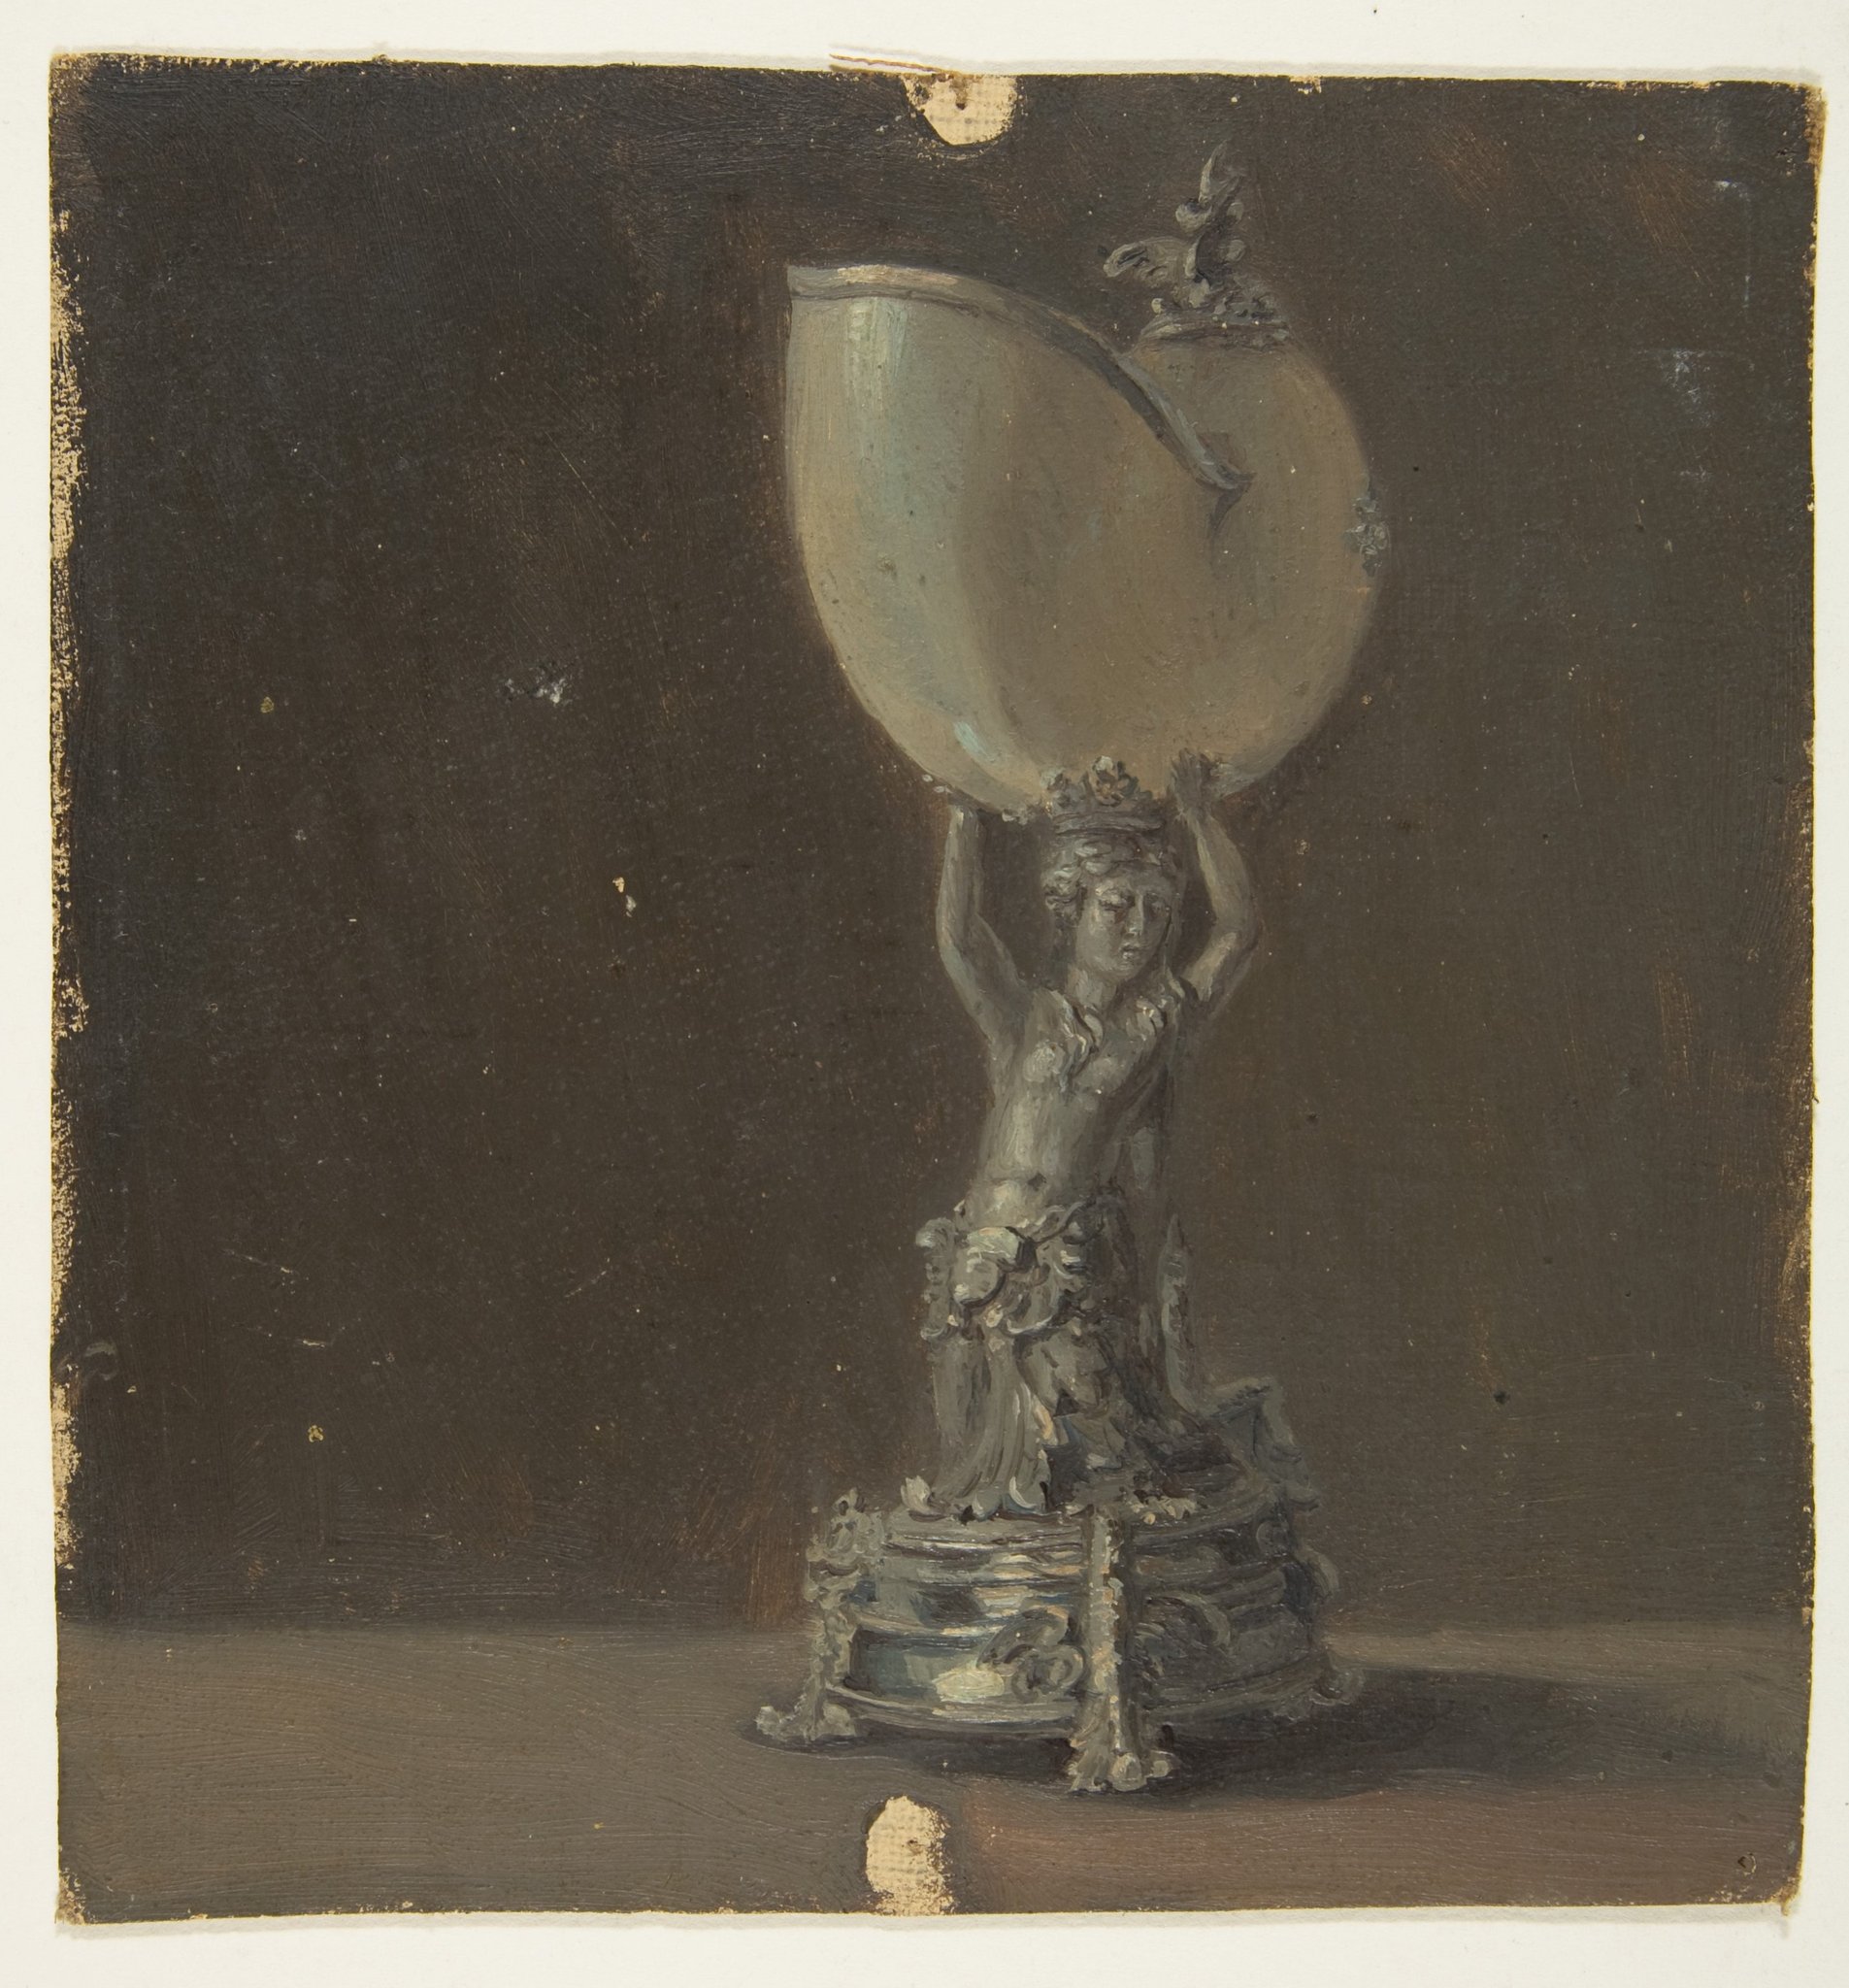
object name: drawing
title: Design for a Lamp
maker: anonymous, french, 19th century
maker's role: artist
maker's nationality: french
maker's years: 1800-1900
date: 1801-1900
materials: canvas, oil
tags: women